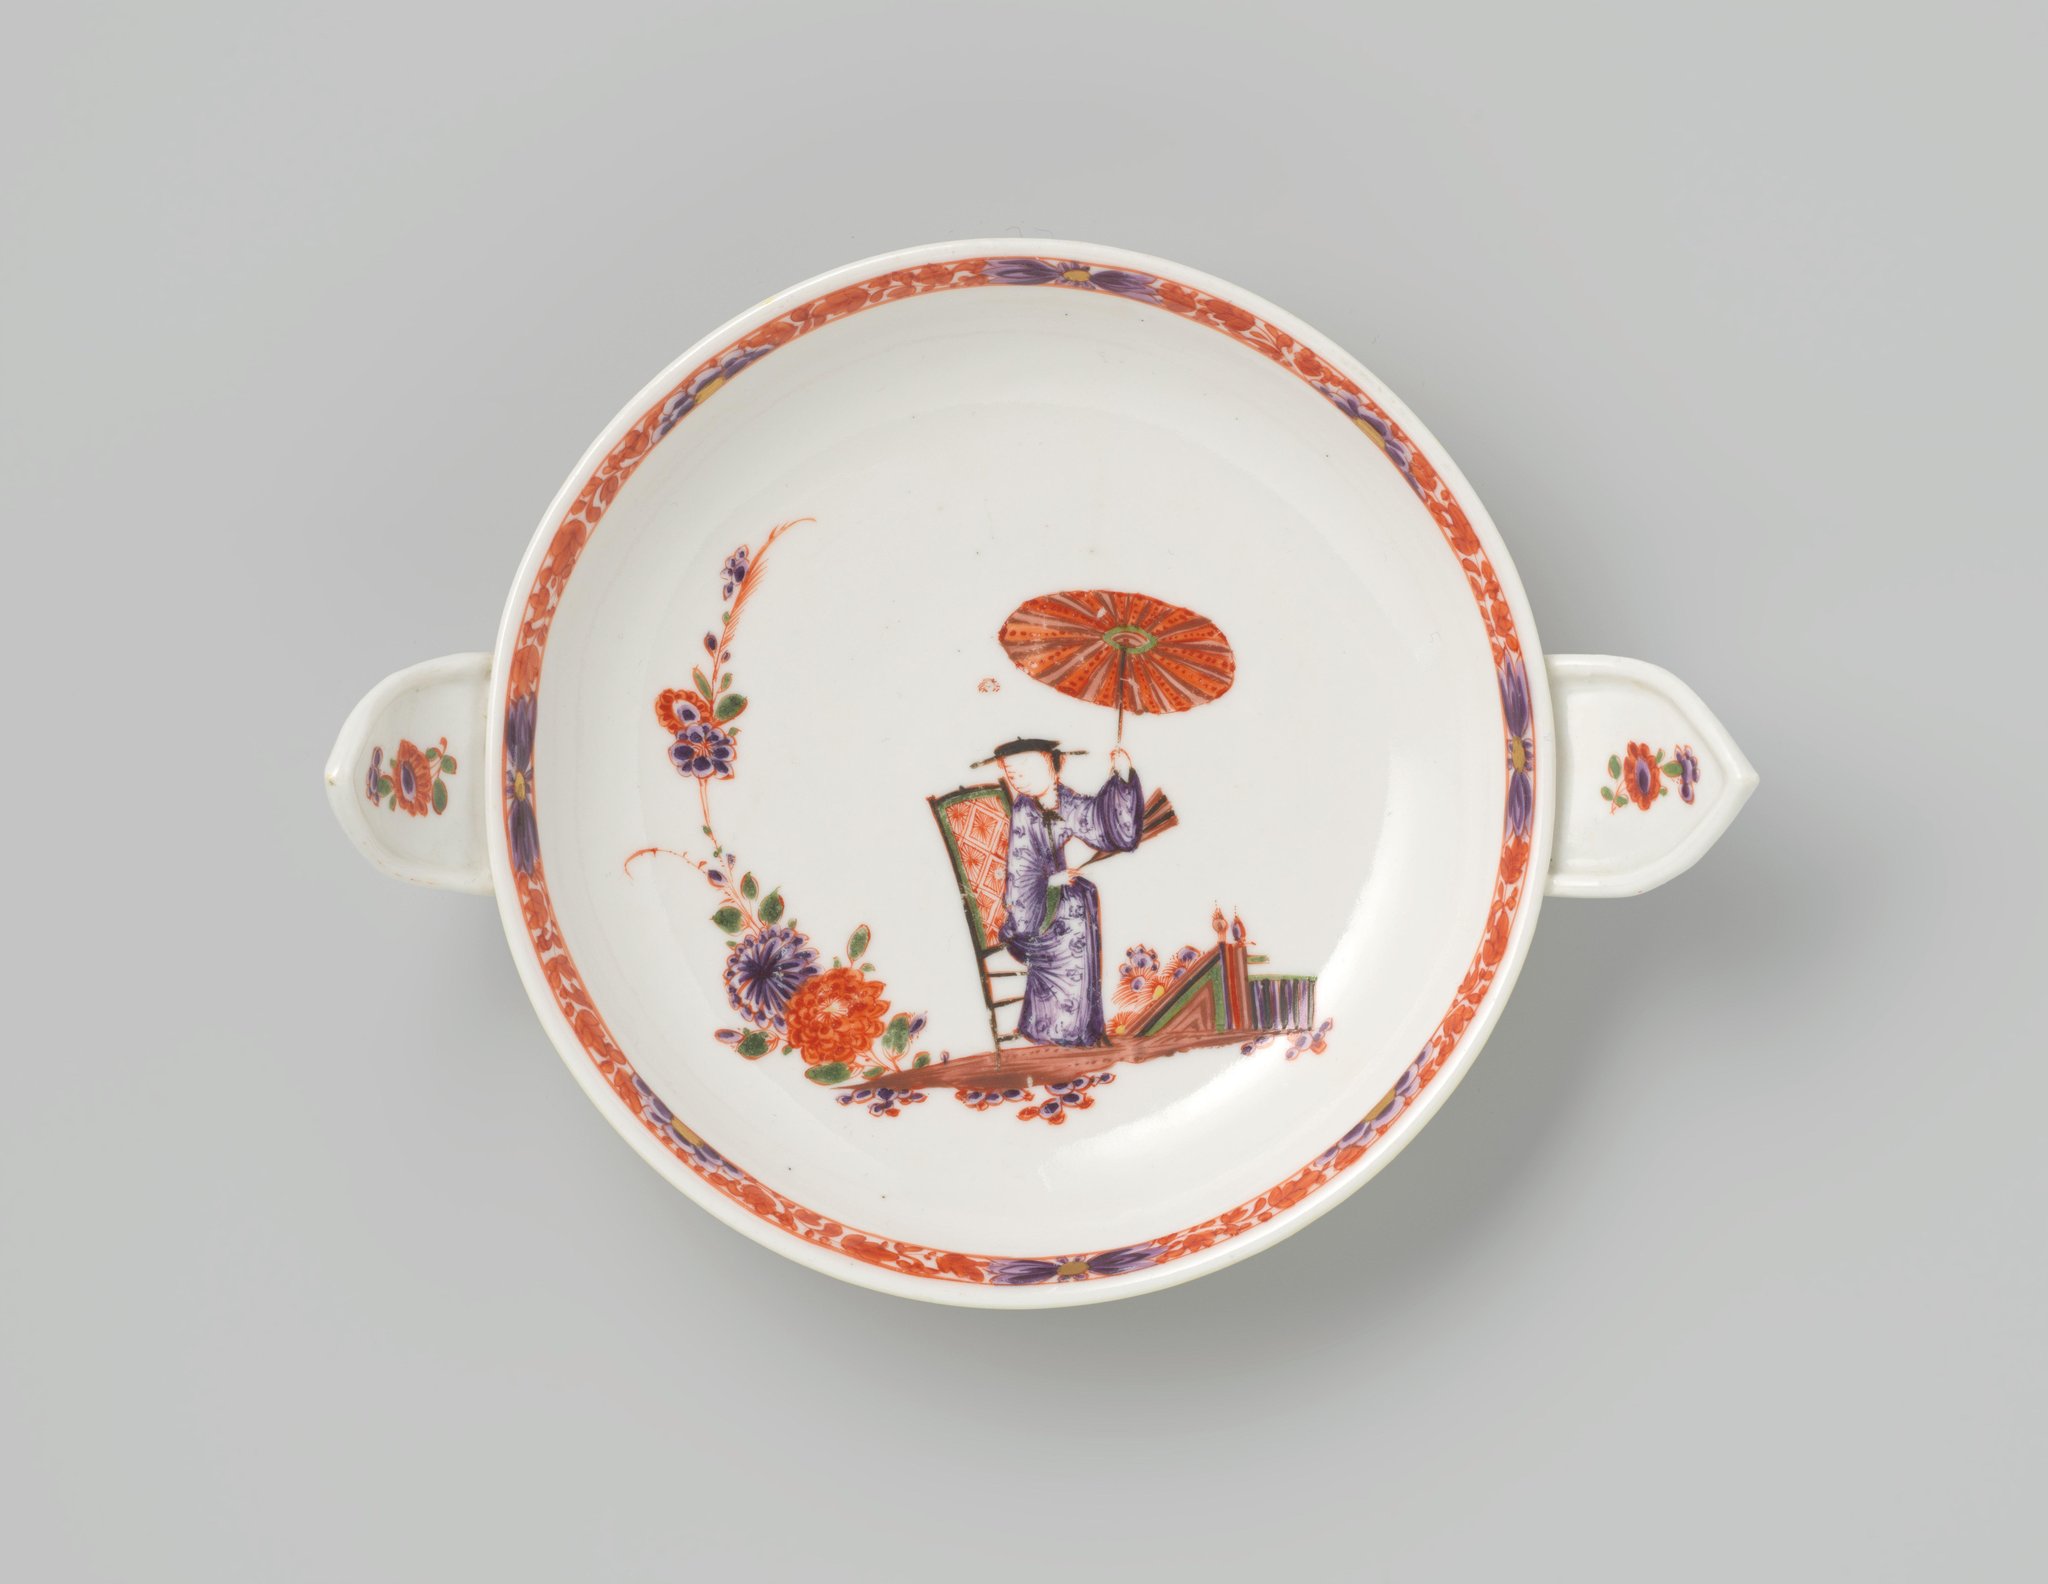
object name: platter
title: Schotel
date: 1730-1735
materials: porcelain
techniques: gilding, painted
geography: meissen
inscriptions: mark: ‘Gekruiste zwaarden’, number: ‘120’, label: ‘Sammlung Dr. FRANZ OPPENHEIMER’, number: ‘NK.3016’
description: Dit object is van 1953 tot en met 2019 vanuit de Rijkscollectie ondergebracht geweest bij het Kunstmuseum in Den Haag. Vergelijkbare kop en schotel geveild bij Sotheby’s London, 5 december 2004, nr. 427.